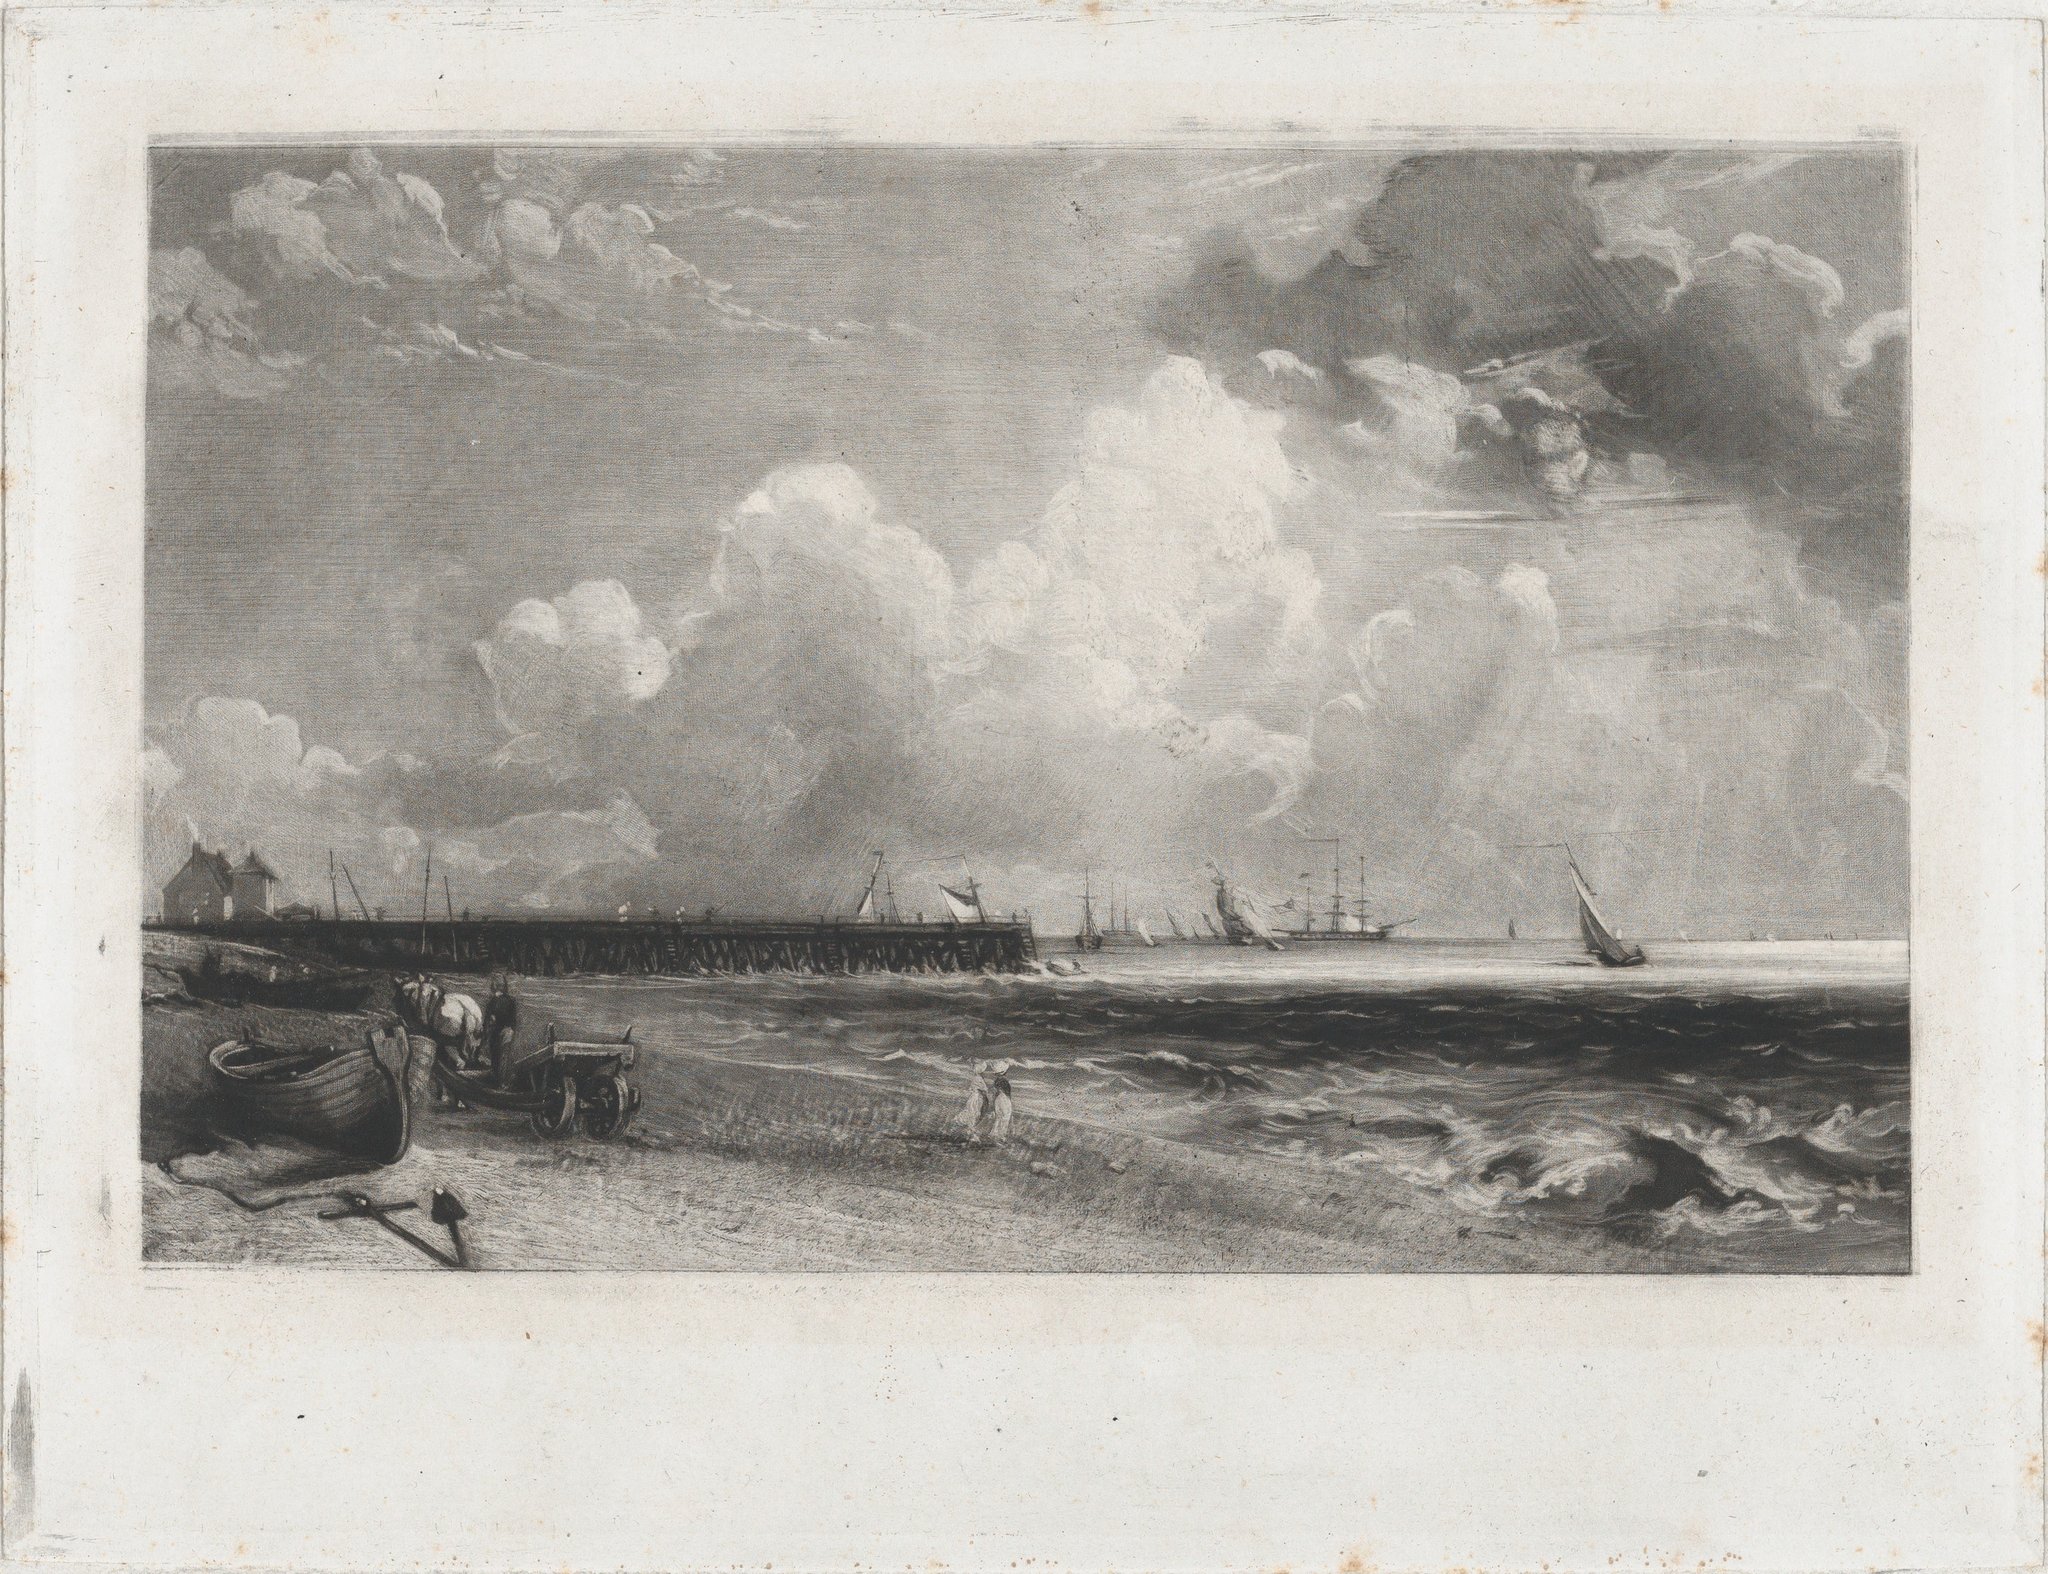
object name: print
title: Yarmouth, Norfolk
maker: david lucas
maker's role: artist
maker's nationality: british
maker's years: 1802-1881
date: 1830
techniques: mezzotint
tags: seascapes,boats,piers